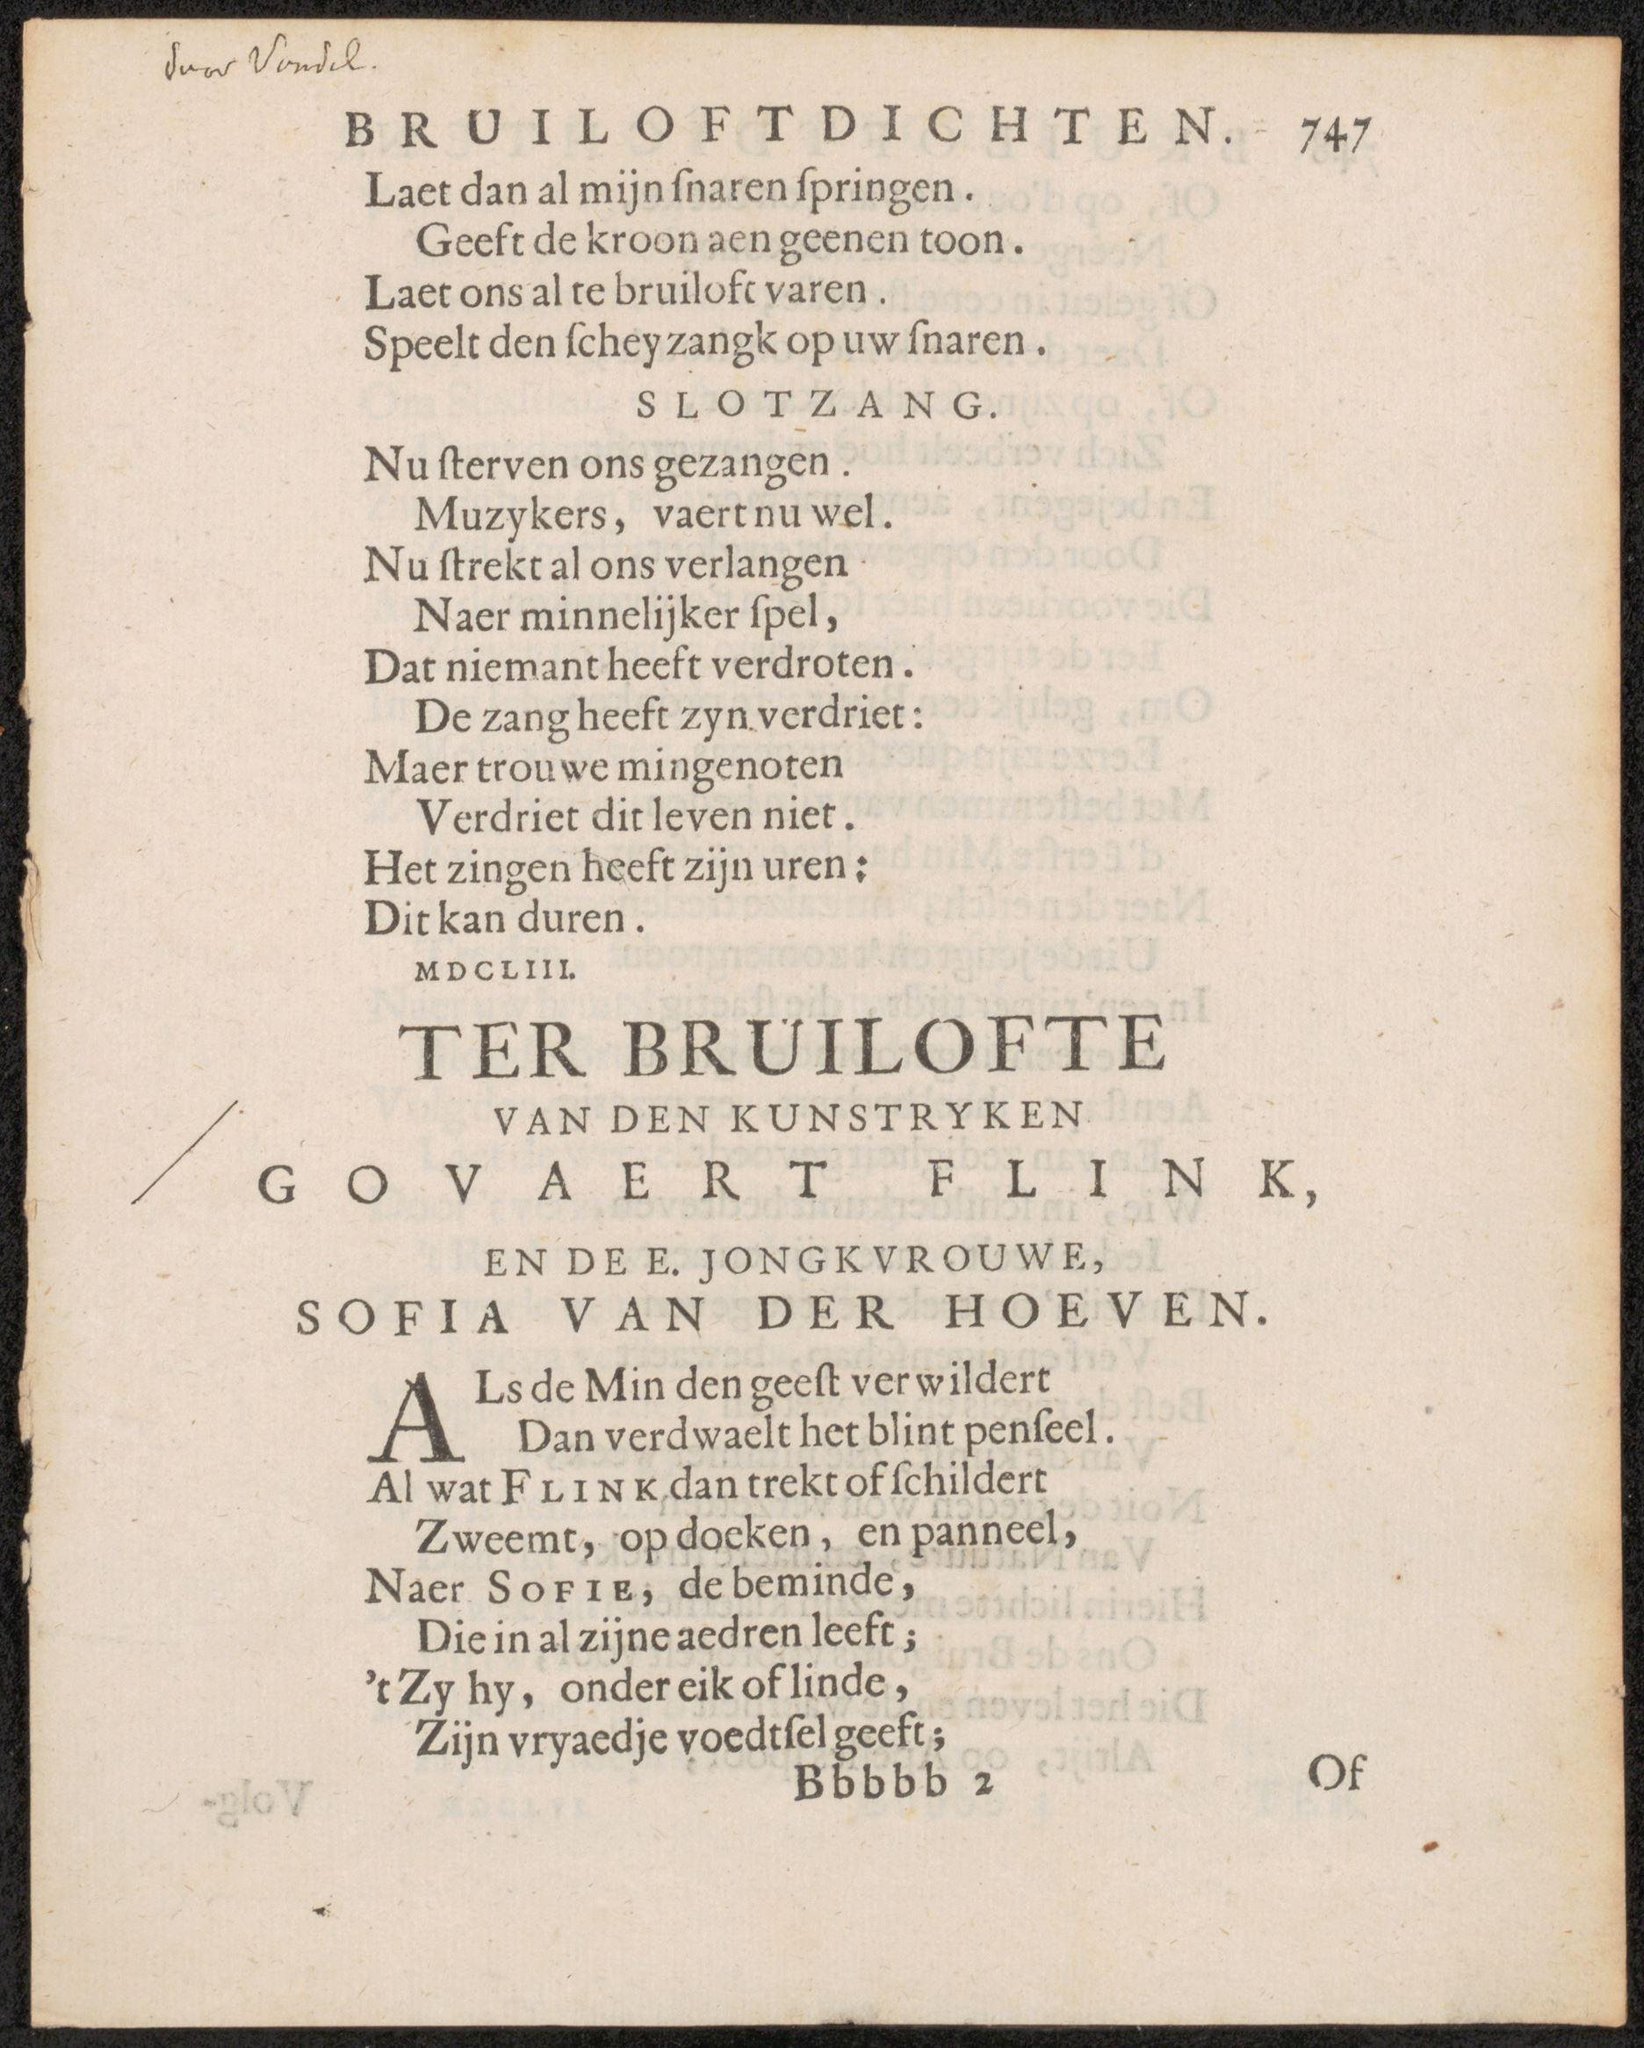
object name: poem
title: Huwelijkszang op Govert Flinck en Sophia van der Hoeven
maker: joost van den vondel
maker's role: dichter, toneelschrijver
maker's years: 1587-1679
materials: ink, paper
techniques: pen, printing, writing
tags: cleves, amsterdam, draughtsman, govert flinck